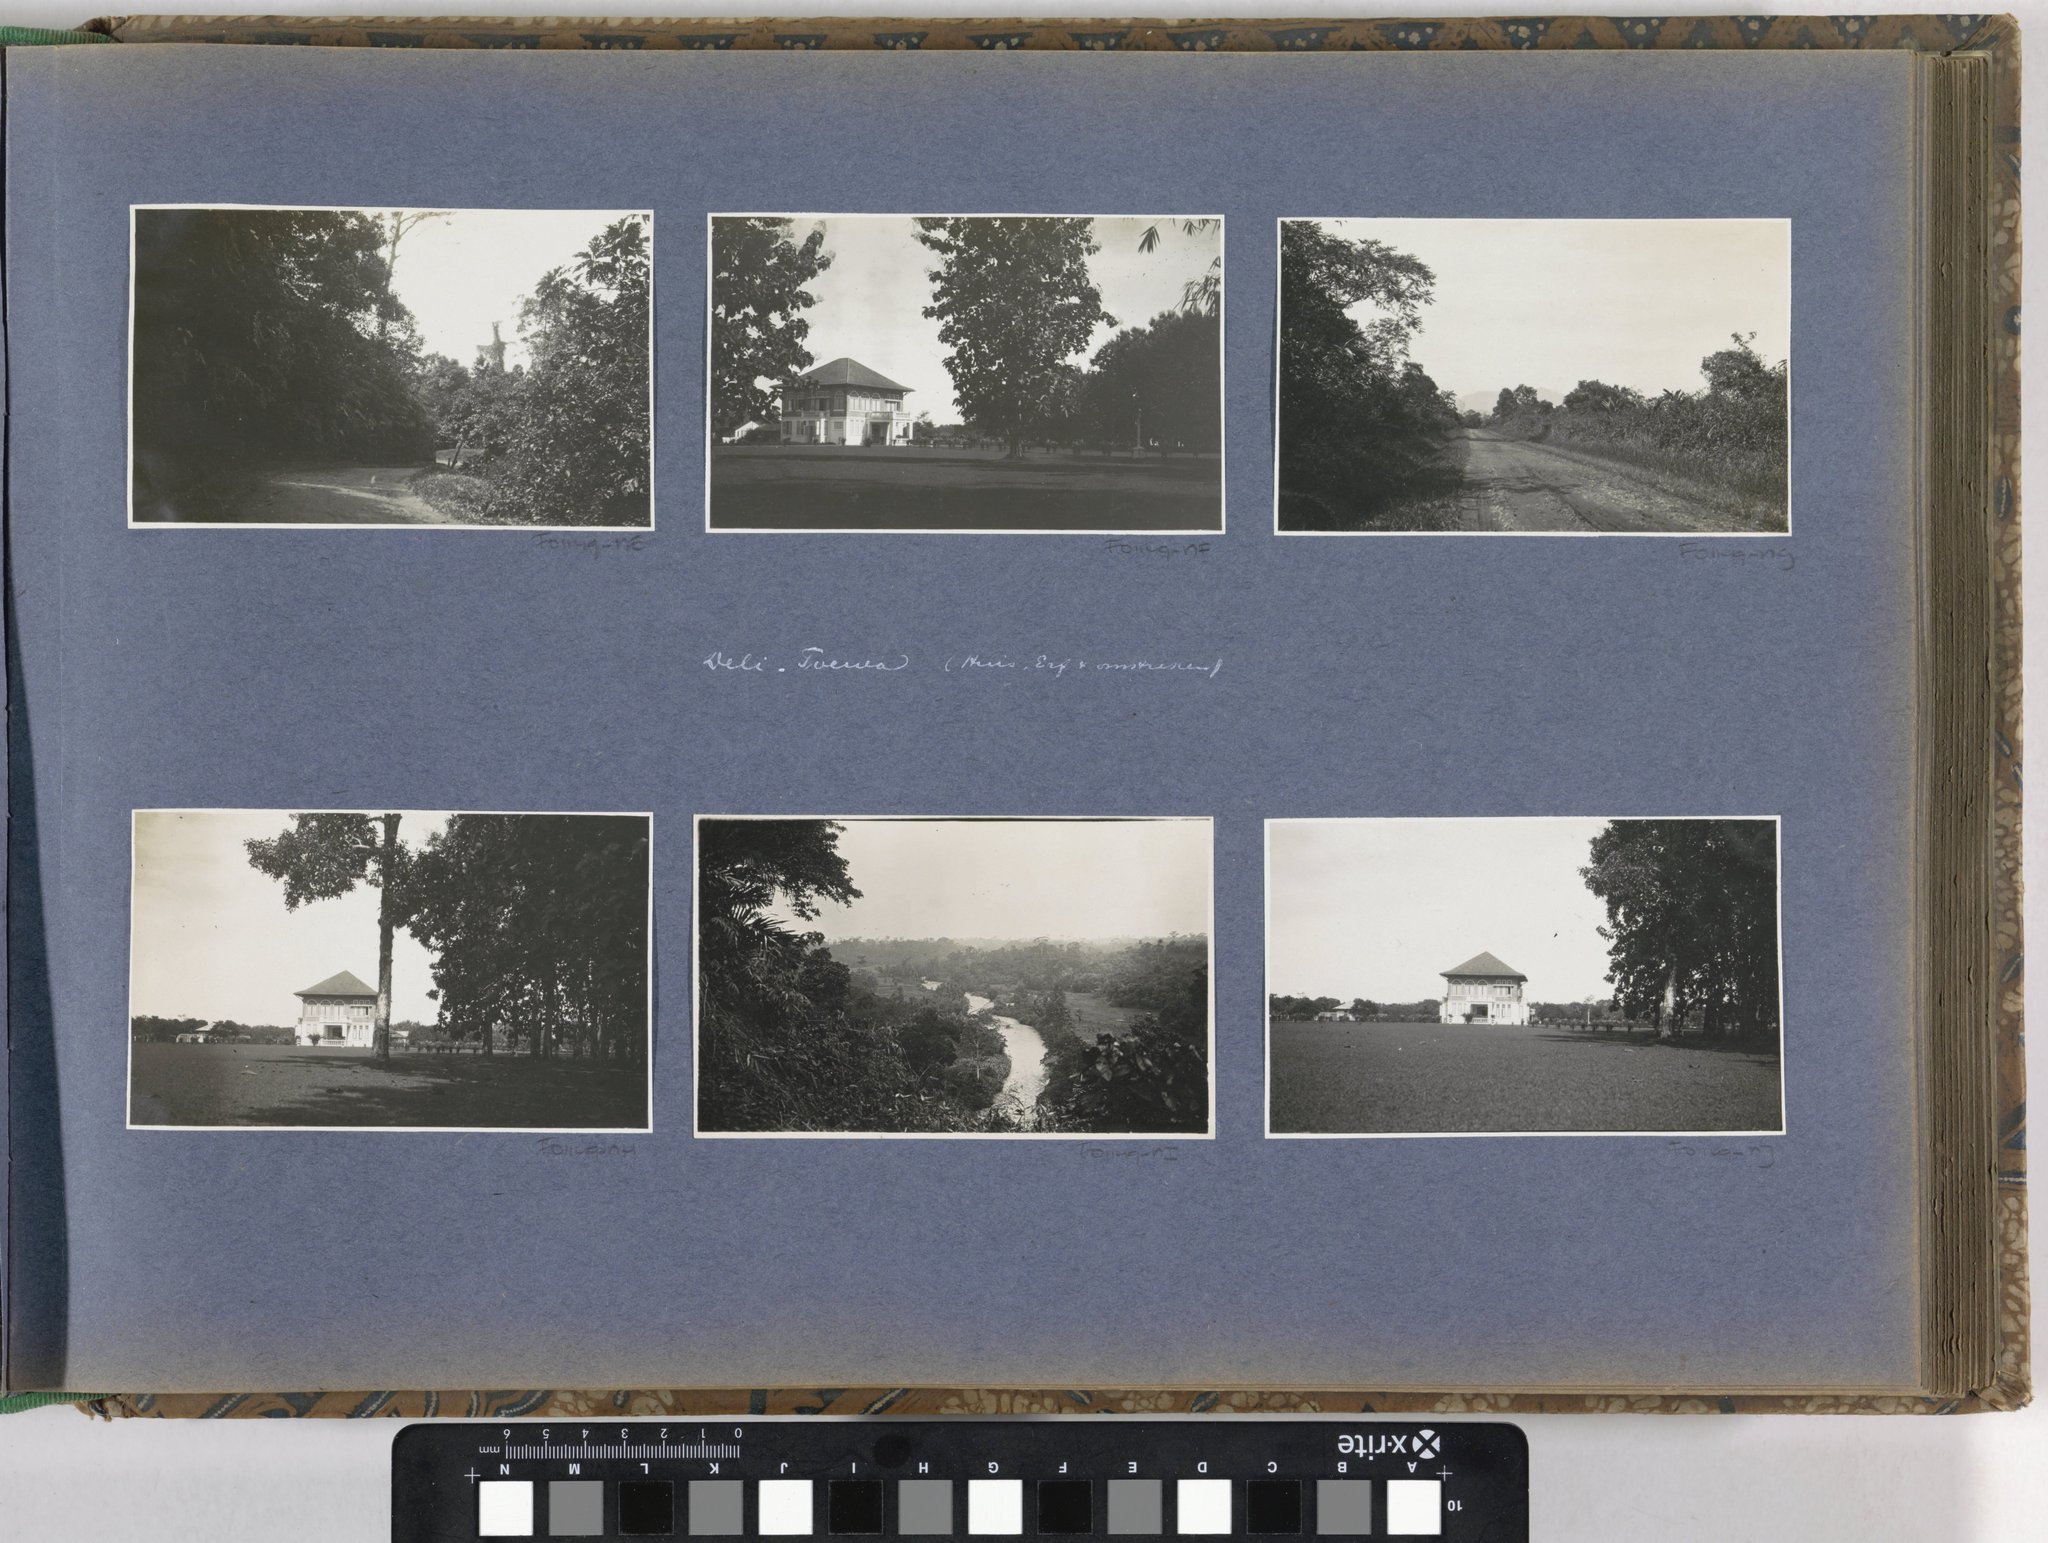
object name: album leaf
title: Huis en tuin in Deli-Toewa op Sumatra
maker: Anonymous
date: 1900-1920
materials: paper, photographic support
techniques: gelatin silver print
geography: sumatra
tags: plantation, garden, rural housing, e.g. country-house, villa, cottage, sumatra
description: Onderdeel van reisalbum met foto's van bedrijvigheid en bezienswaardigheden op Sumatra en Java en van de reis naar en van Nederlands-Indië.